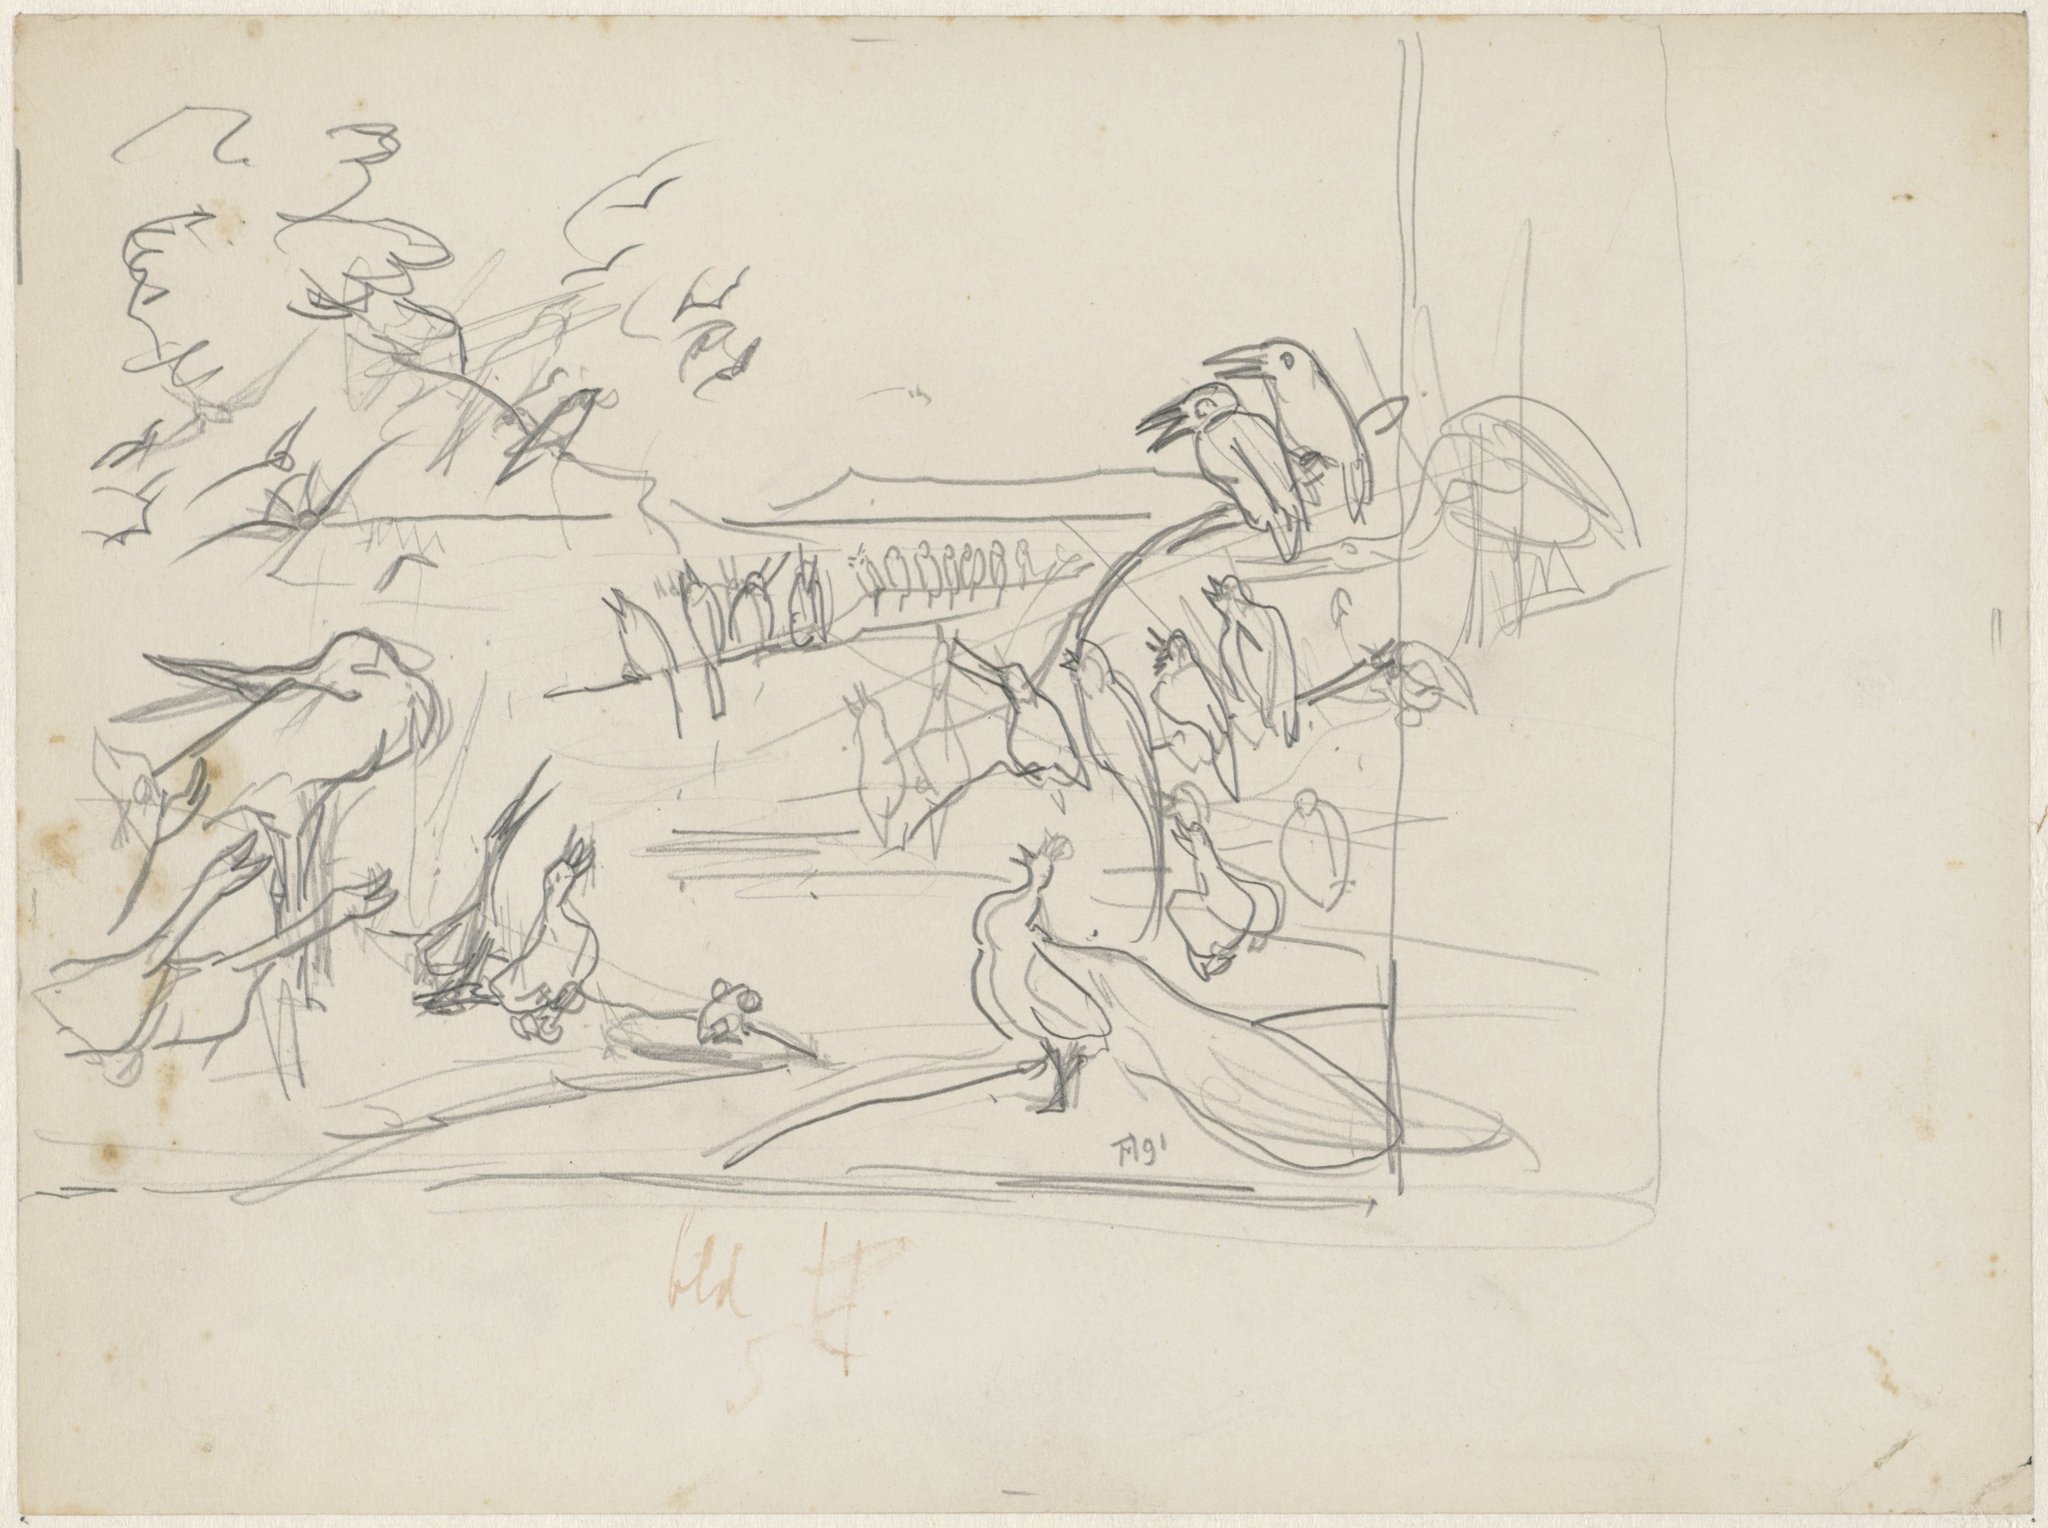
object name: drawing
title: Schets voor illustratie in Hoe de vogels aan een koning kwamen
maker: theo van hoytema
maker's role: draughtsman, painter, print maker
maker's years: 1863-1917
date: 1891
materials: paper, pencil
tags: birds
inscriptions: date: ‘91’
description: Voorstudie voor prent in 'Hoe de vogels aan een koning kwamen'.